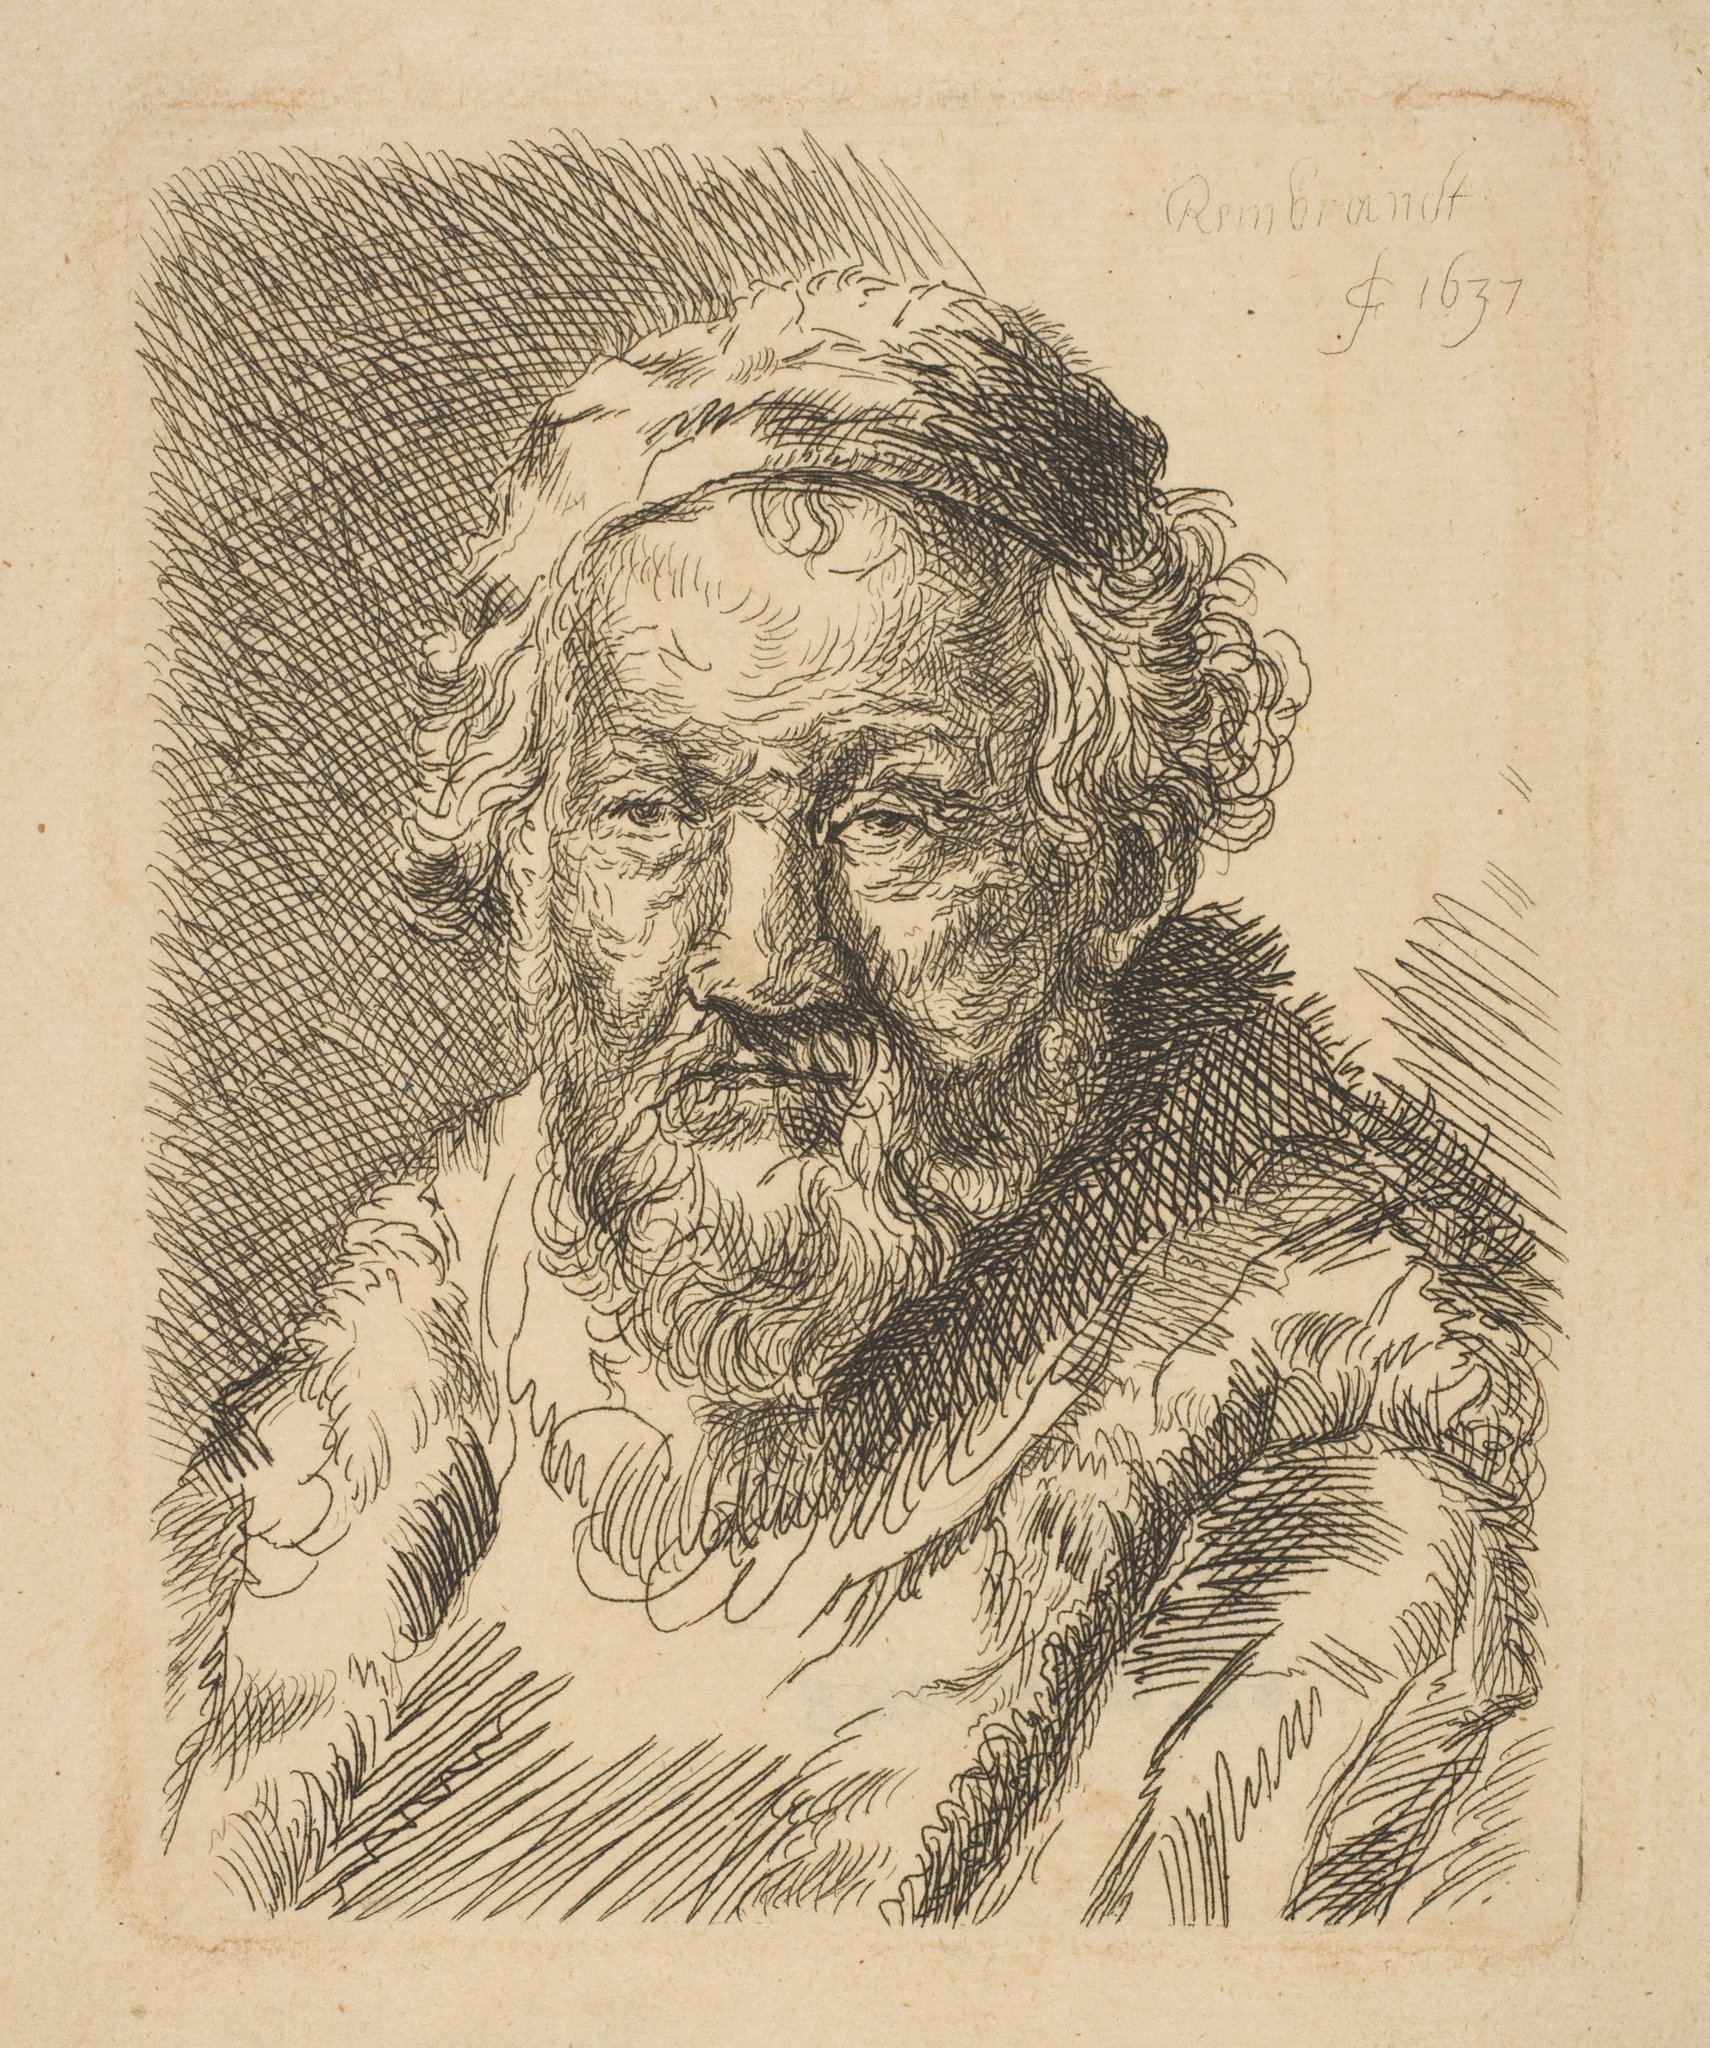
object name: print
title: Bust of an Old Man in a Coat and Fur Collar (copy)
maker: rembrandt van rijn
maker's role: artist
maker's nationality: dutch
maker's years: 1606-1669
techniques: etching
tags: men,portraits